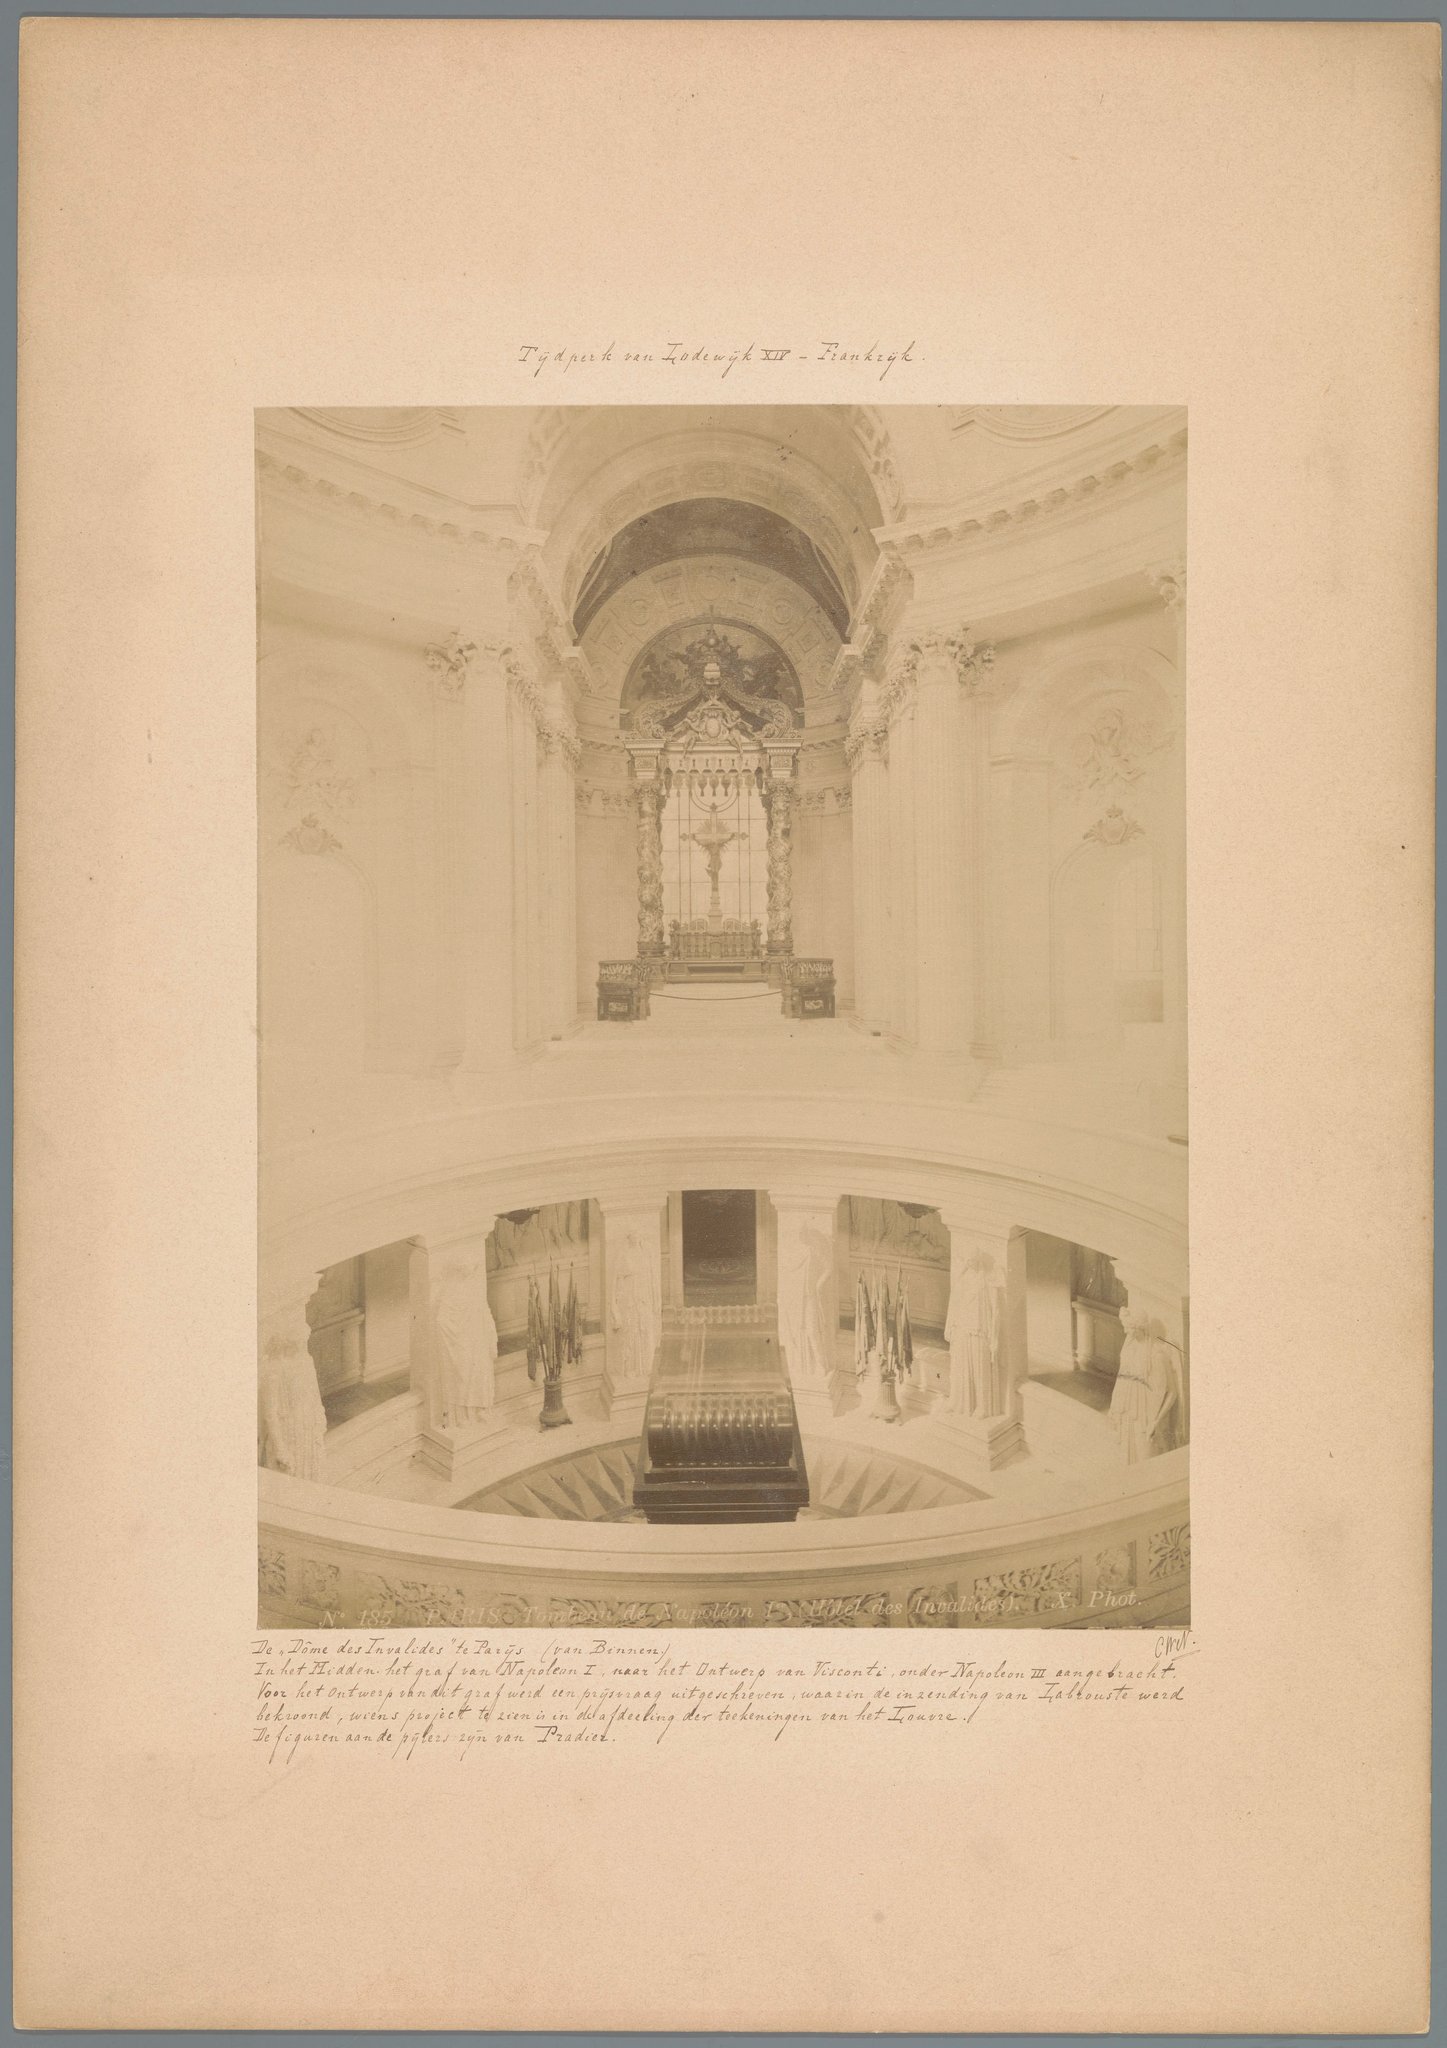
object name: photograph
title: PARIS Tombeau de Napoléon Ien (Hôtel des Invalides).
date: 1875-1900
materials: cardboard, photographic support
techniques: albumen print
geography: dome of the invalides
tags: parts of church interior: dome, grave, tomb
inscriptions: number: ‘No. 185’, collector's mark: ‘KUNSTNIJVERHEIDSCHOOL QUELLINUS AMSTERDAM FRANS HALSSTRAAT 14.’, collector's mark: ‘INSTITUUT VOOR KUNST-NIJVERHEIDSONDERWIJS GABRIËL METSUSTRAAT No. 16 AMSTERDAM’, inscription: ‘Tijdperk van Lodwijk XIV - Frankrijk.’, inscription: ‘CWN.’